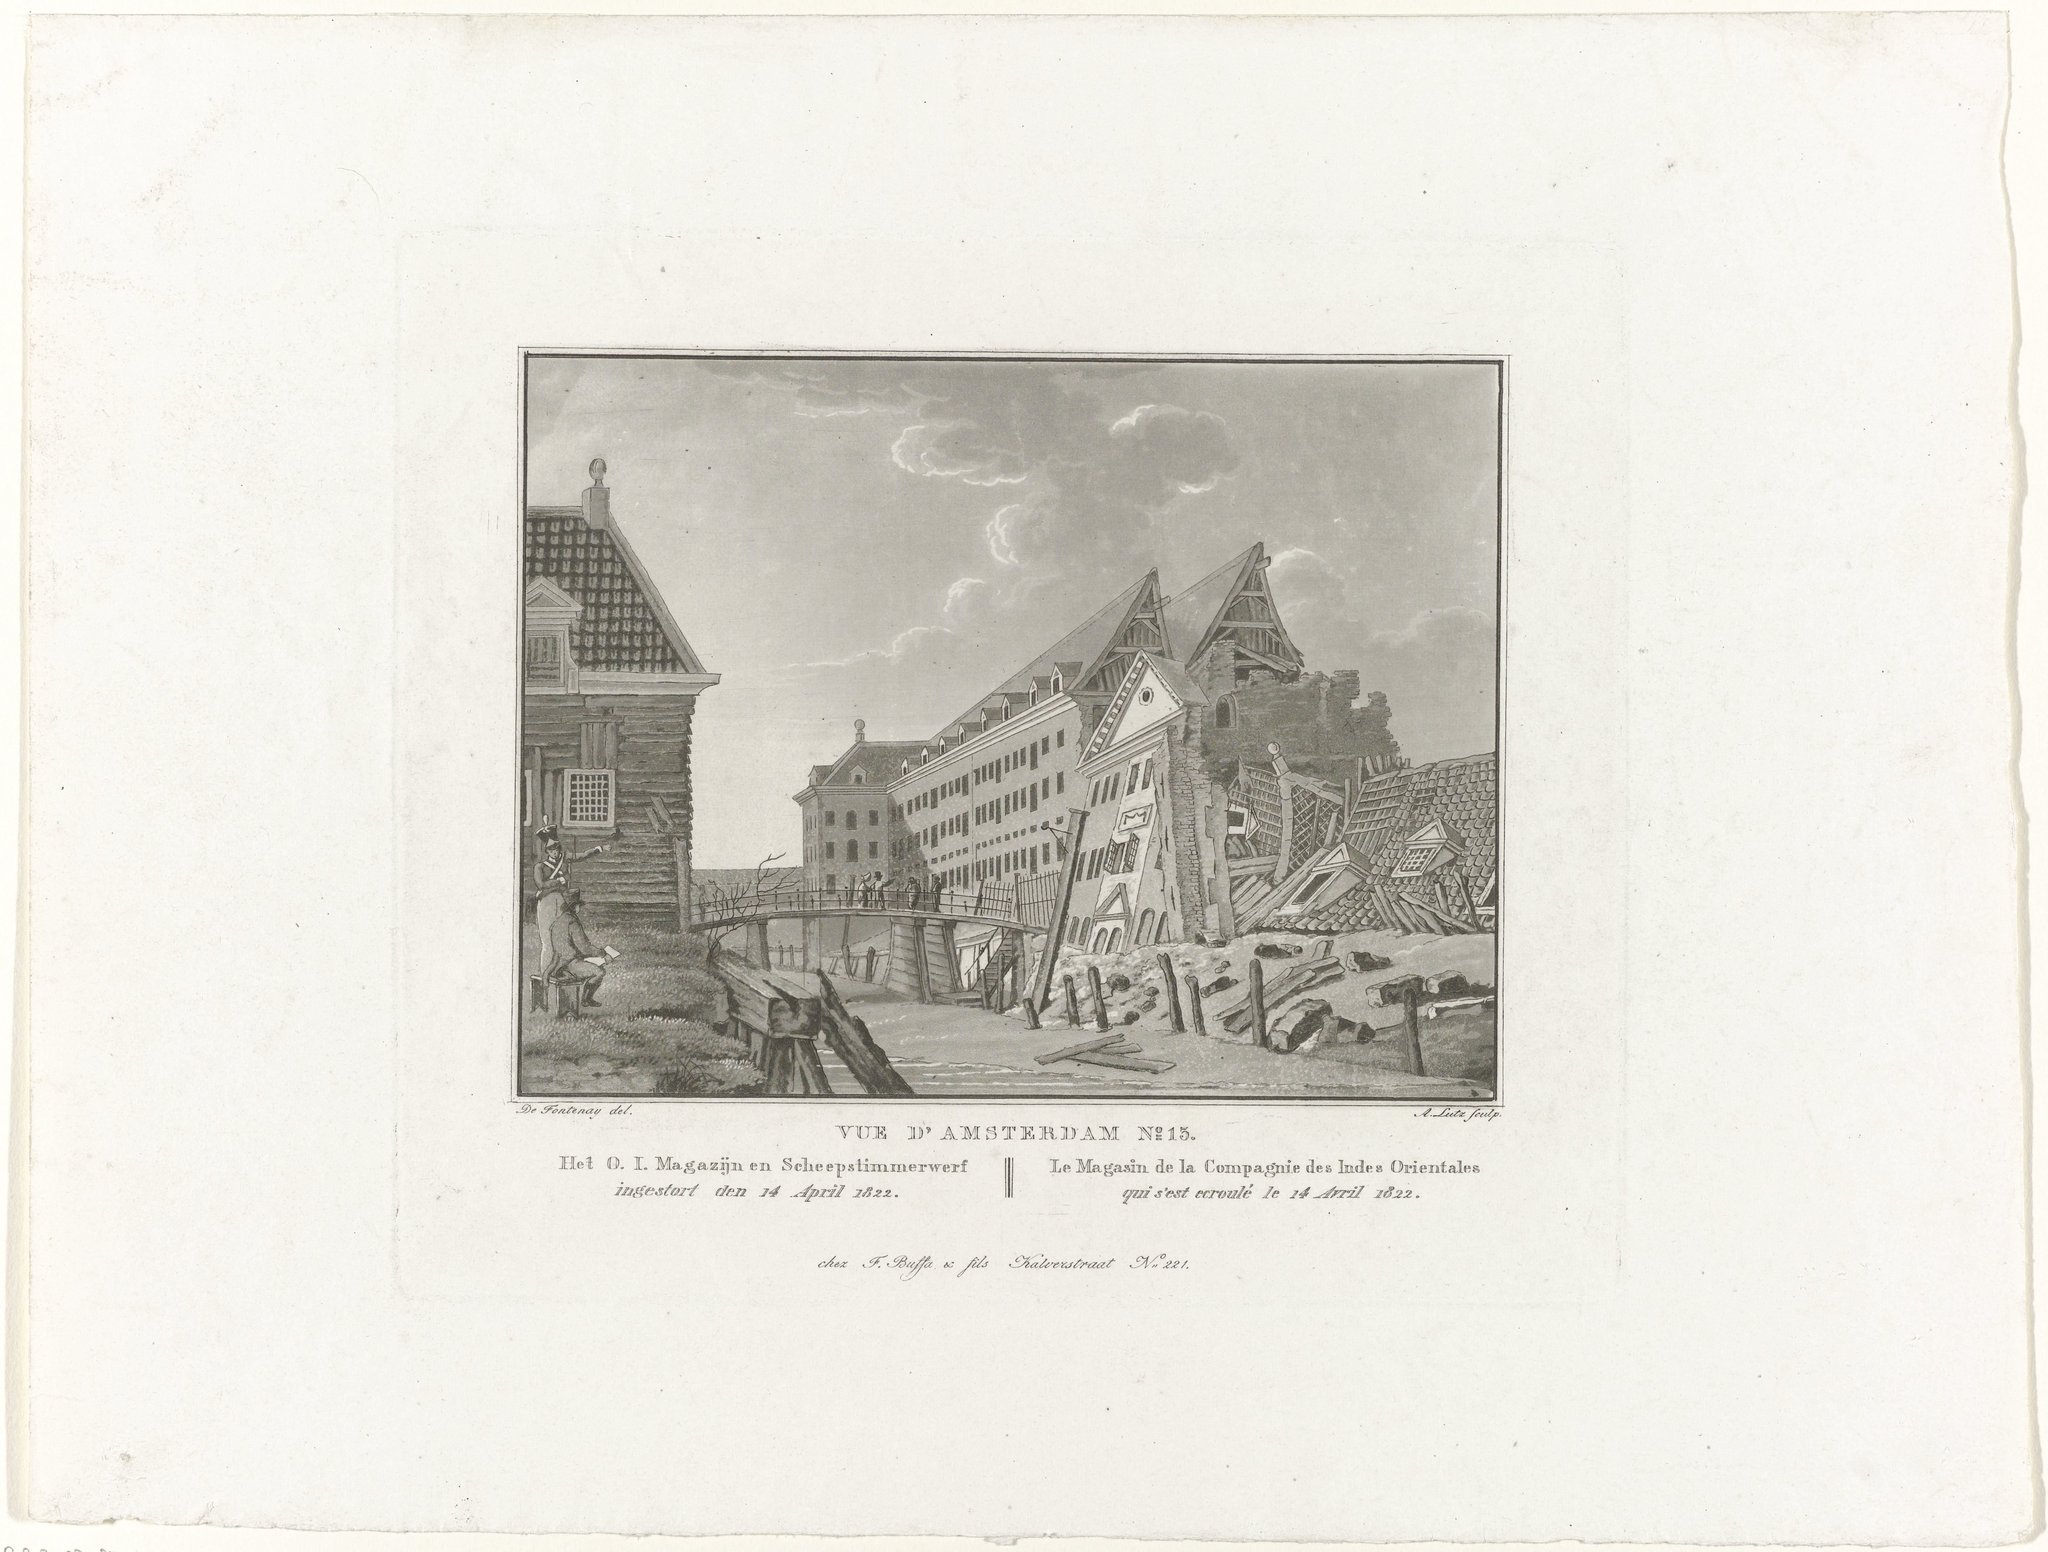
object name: print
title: Ruïne van het Oost-Indisch Zeemagazijn, 1822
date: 1822-1825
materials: paper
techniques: aquatint, etching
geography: netherlands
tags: ruin of a building ~ architecture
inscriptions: collector's mark: Lugt 2228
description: Ruïne van het Oost-Indisch Zeemagazijn te Amsterdam, na de instorting op 13-14 april 1822.